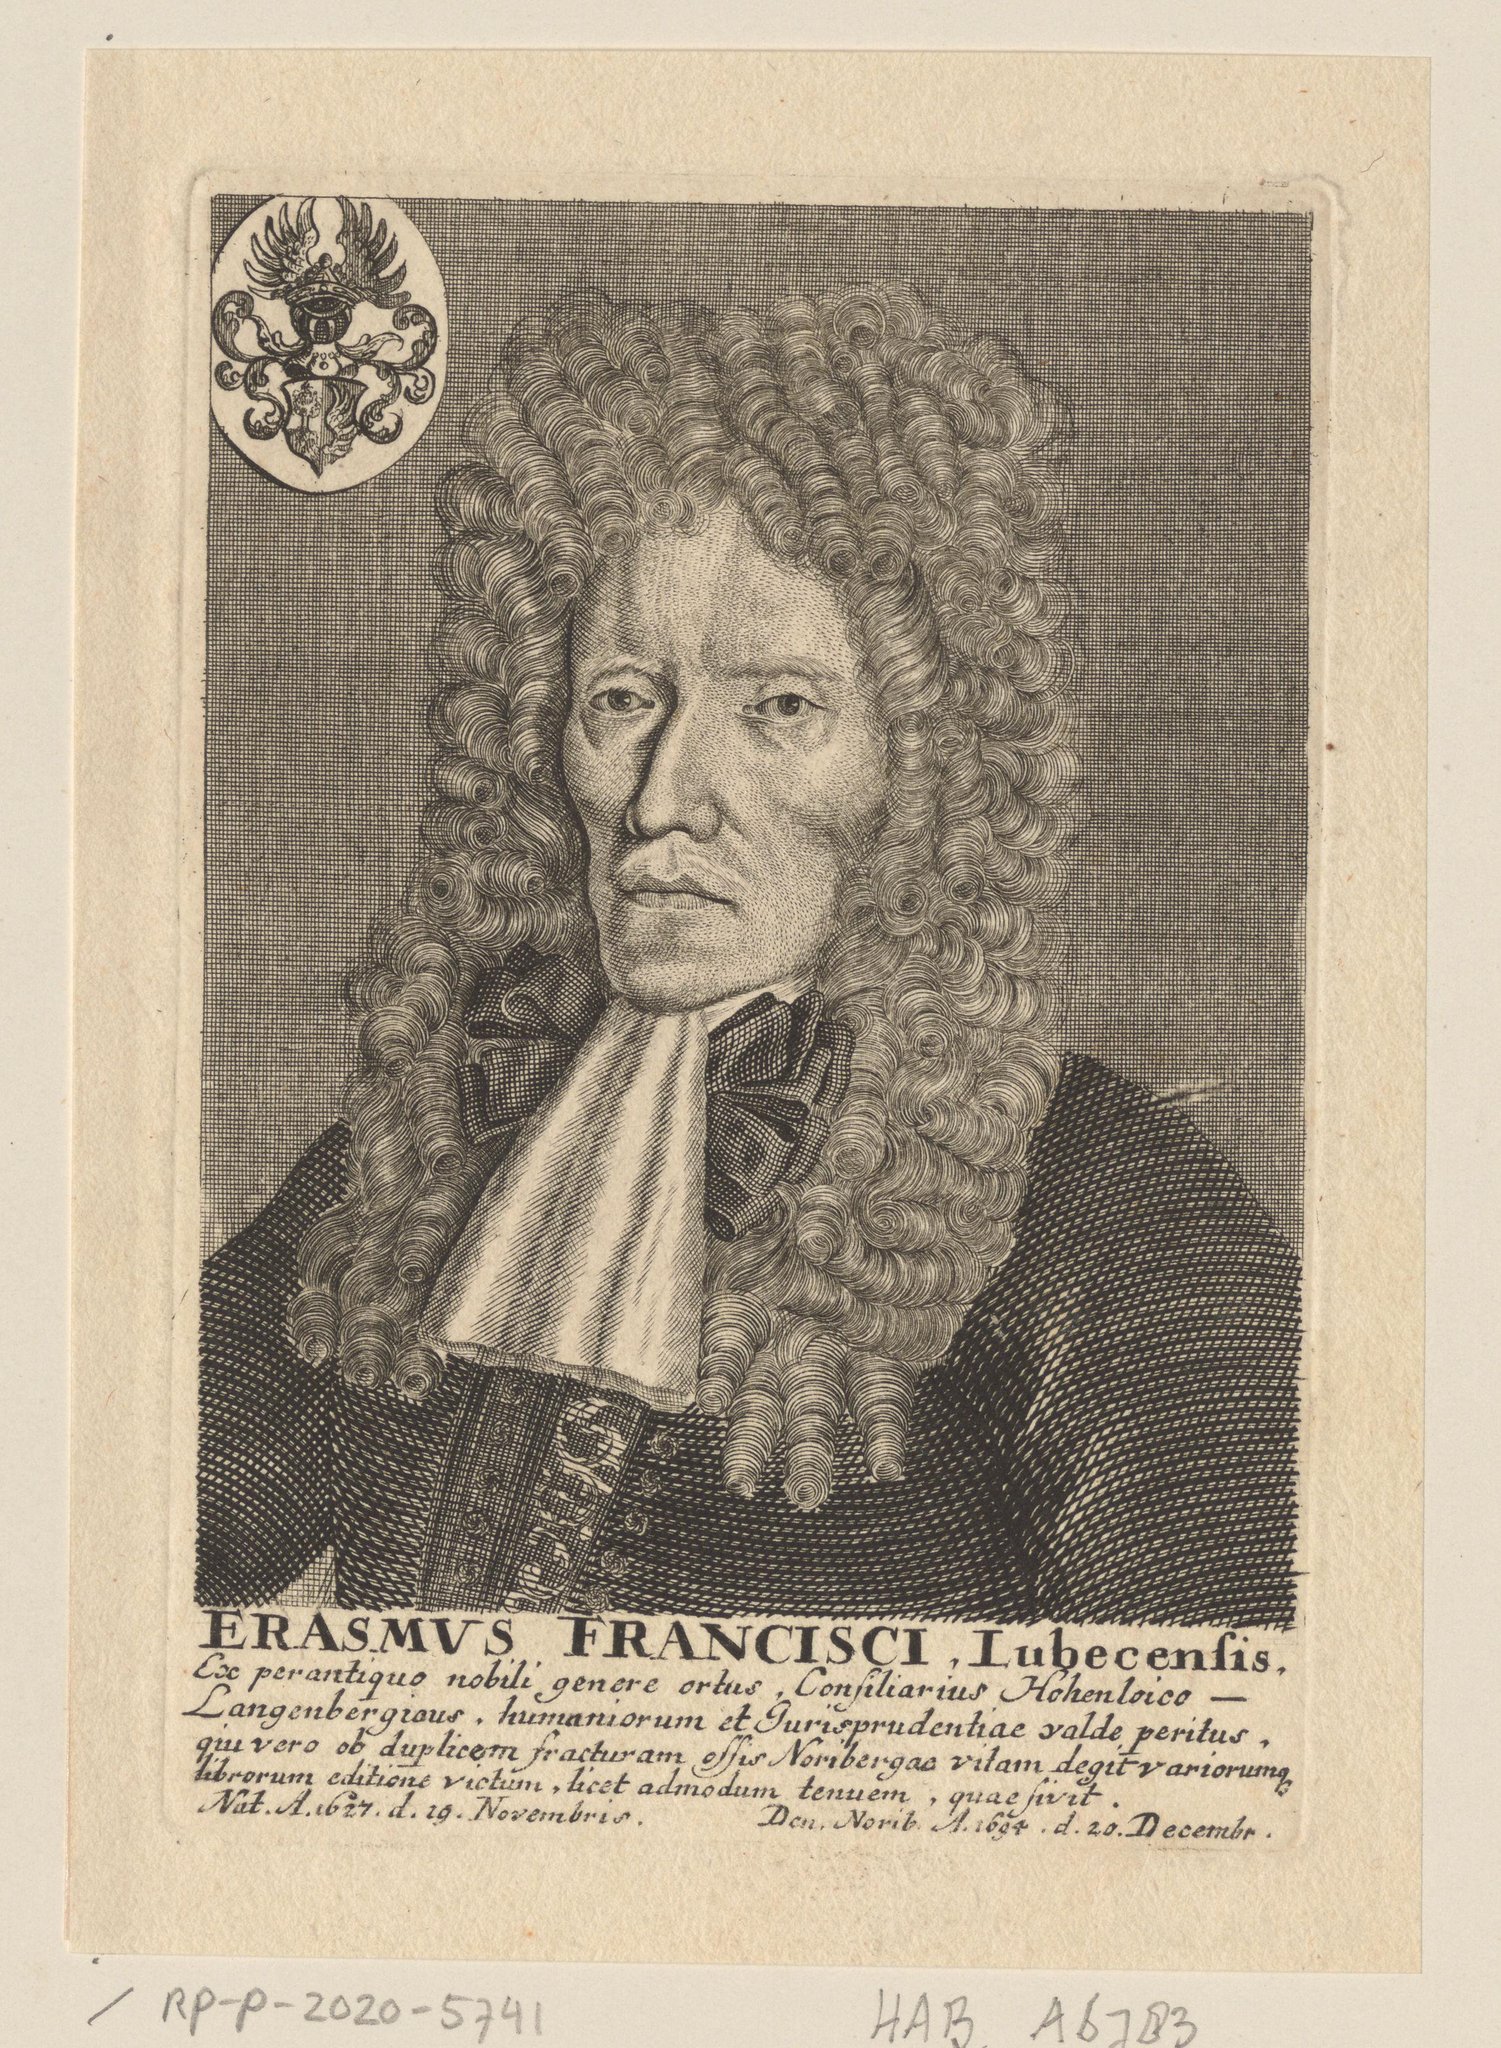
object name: print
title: Portret van Erasmus Finx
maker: Anonymous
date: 1720-1725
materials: paper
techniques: engraving, etching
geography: germany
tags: erasmus finx, historical persons, portrait of a writer, armorial bearing, heraldry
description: Prent mogelijk uit: Roth-Scholtz, Friedrich. Icones virorum omnium ordinum eruditione omnique item genere (...). Neurenberg: erven Johann Daniel Tauber, 1725.